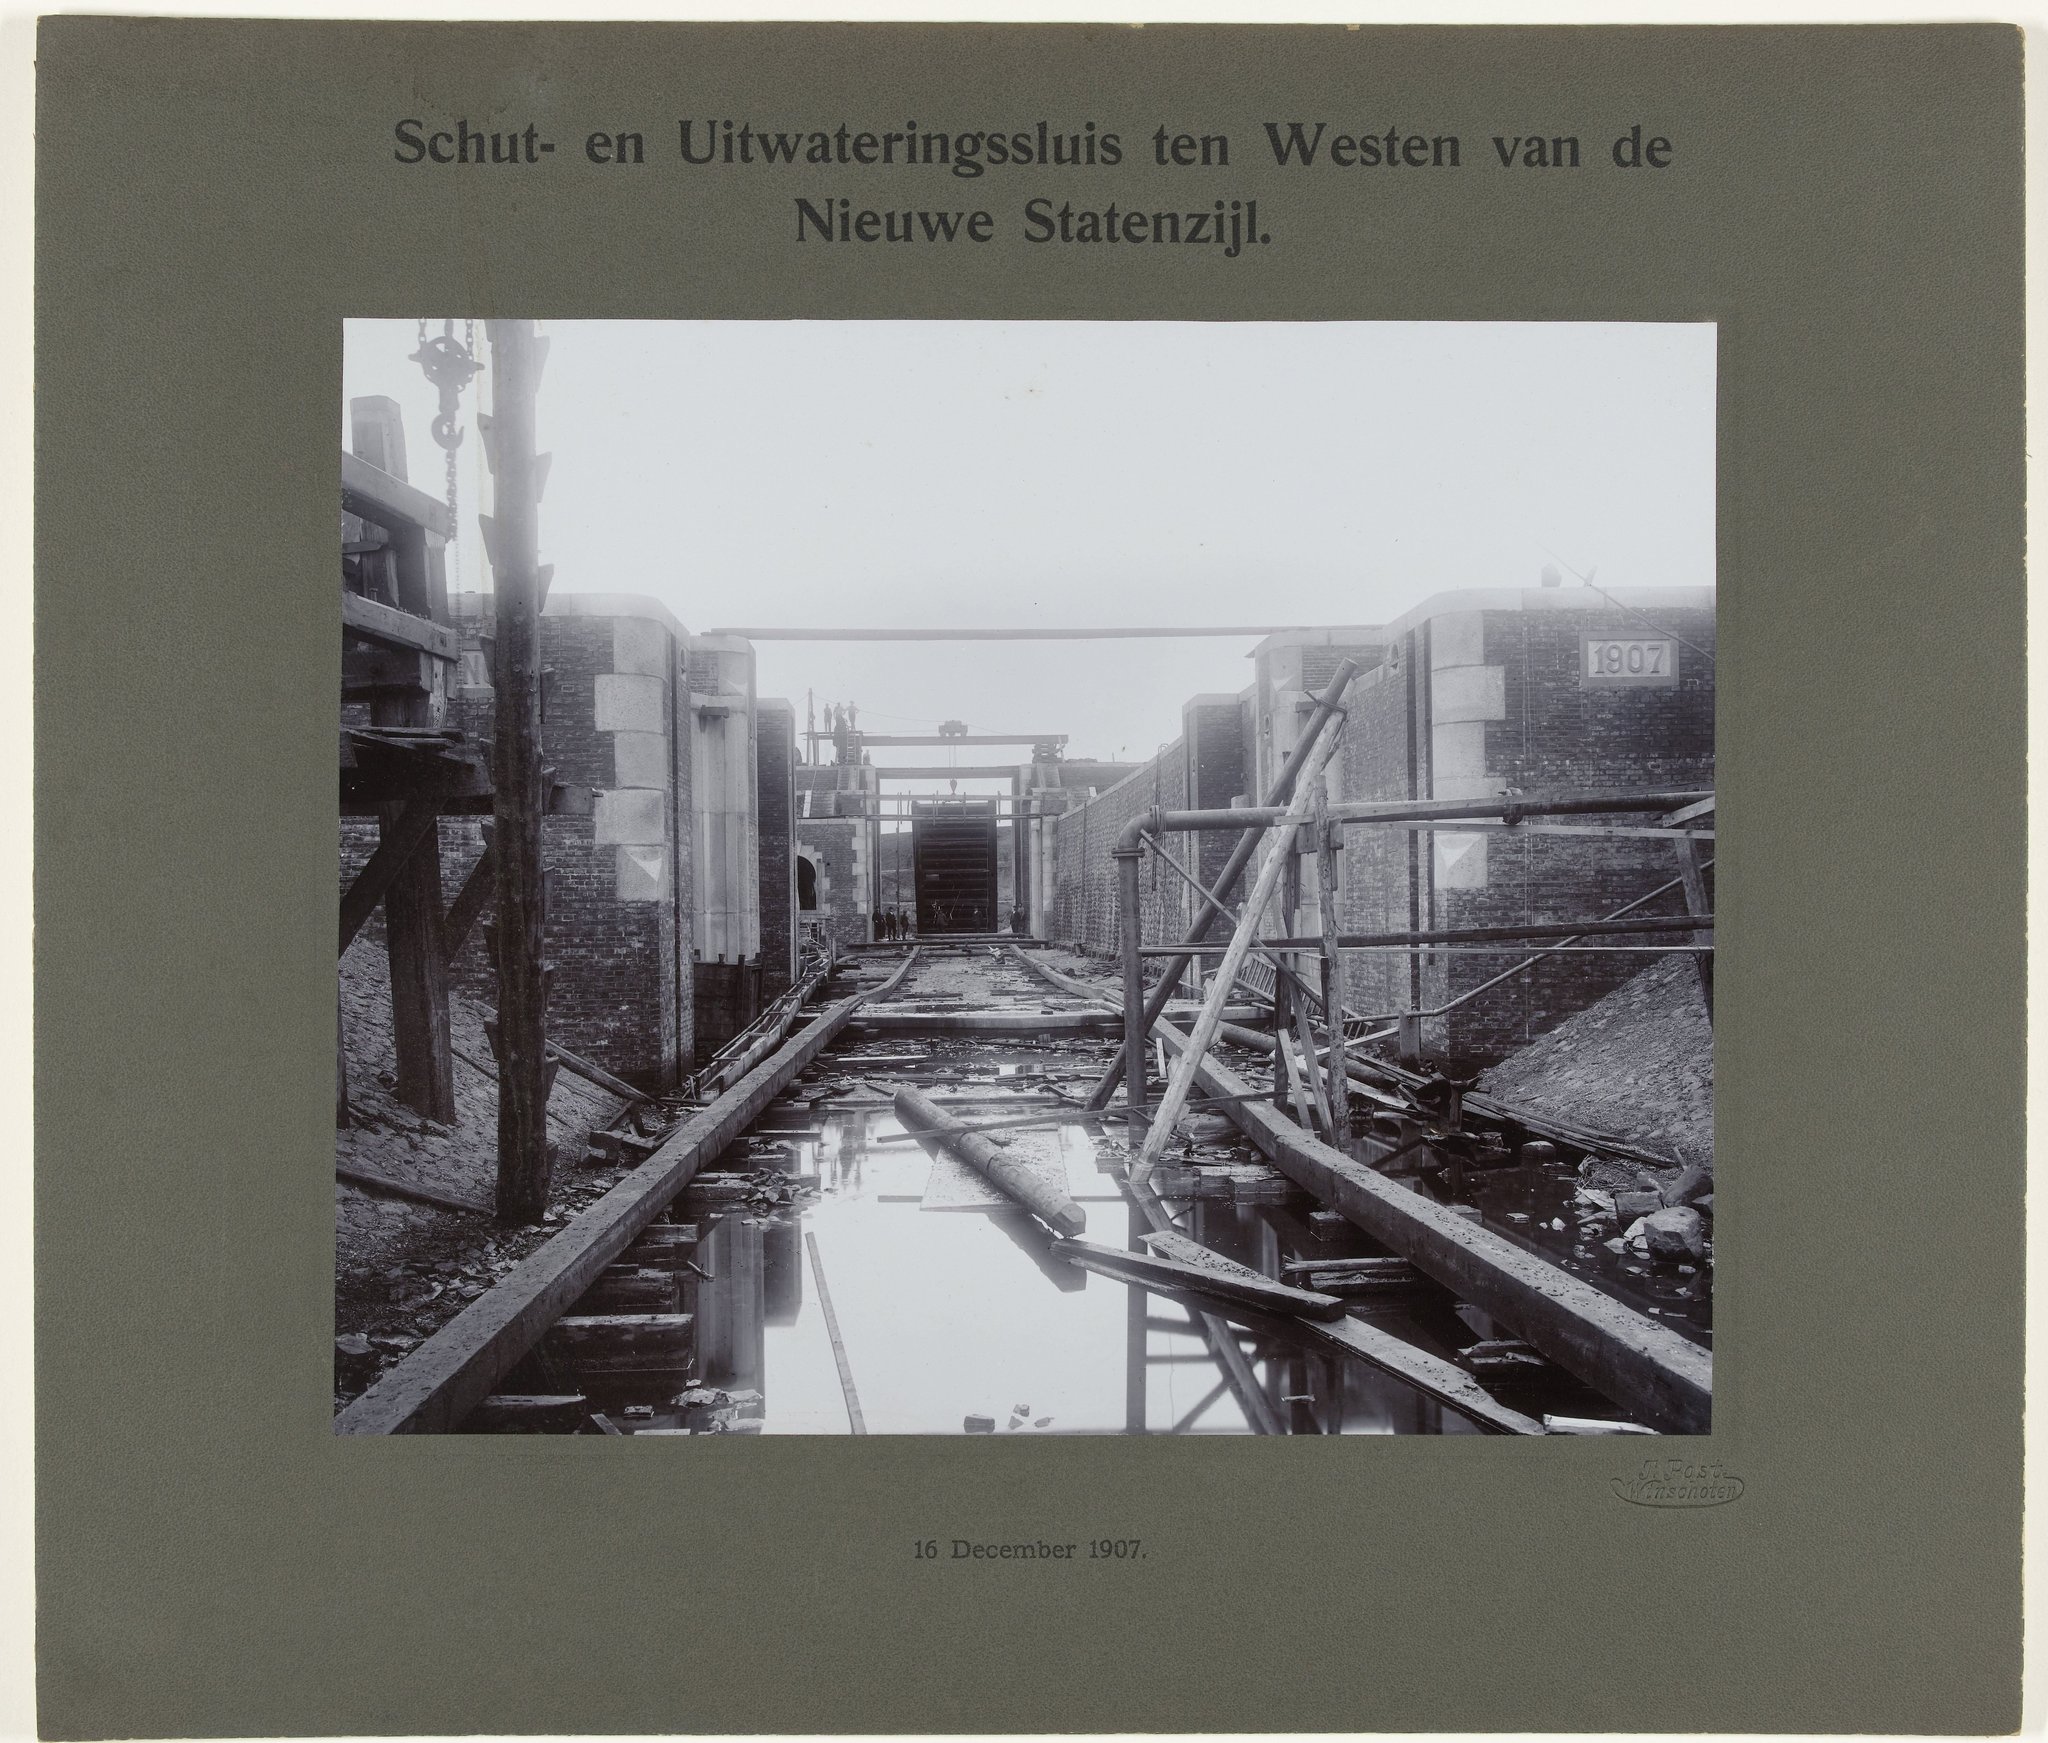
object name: photograph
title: Schut- en Uitwateringssluis ten Westen van de Nieuwe Statenzijl 1907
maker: tonnis post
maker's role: fotograaf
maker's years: 1877-1930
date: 1907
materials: cardboard, paper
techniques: photography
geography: winschoten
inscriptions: date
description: Een van 8 foto's in cassette aangaande een sluis (bij Nieuwe Statenzijl). Foto op blauwgrijs karton geplakt, cassette: paars / bruin. Gedateerd. Opmerking: zie NG-1976-36-B-1 t/m 8.